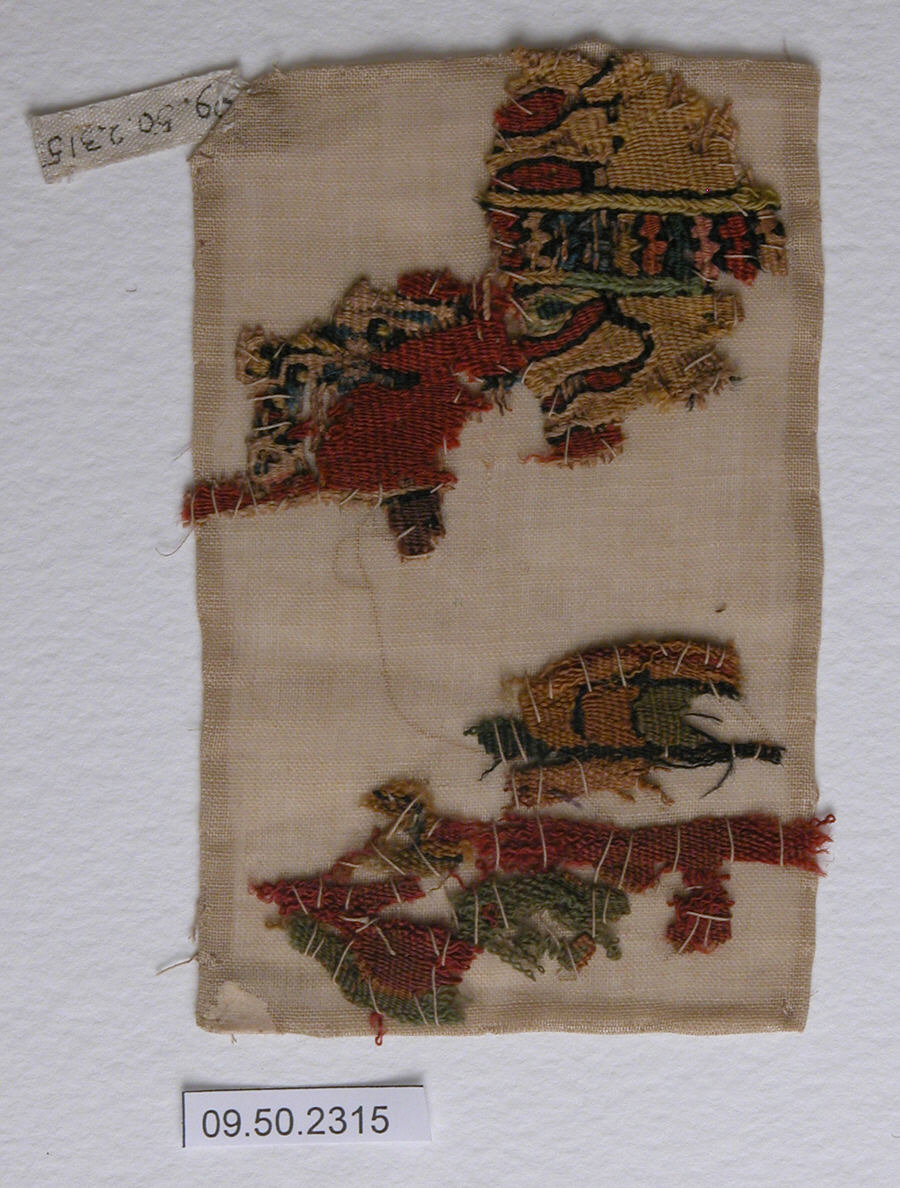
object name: textile fragment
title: Textile Fragments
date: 501-700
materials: linen, wool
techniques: weave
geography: egypt